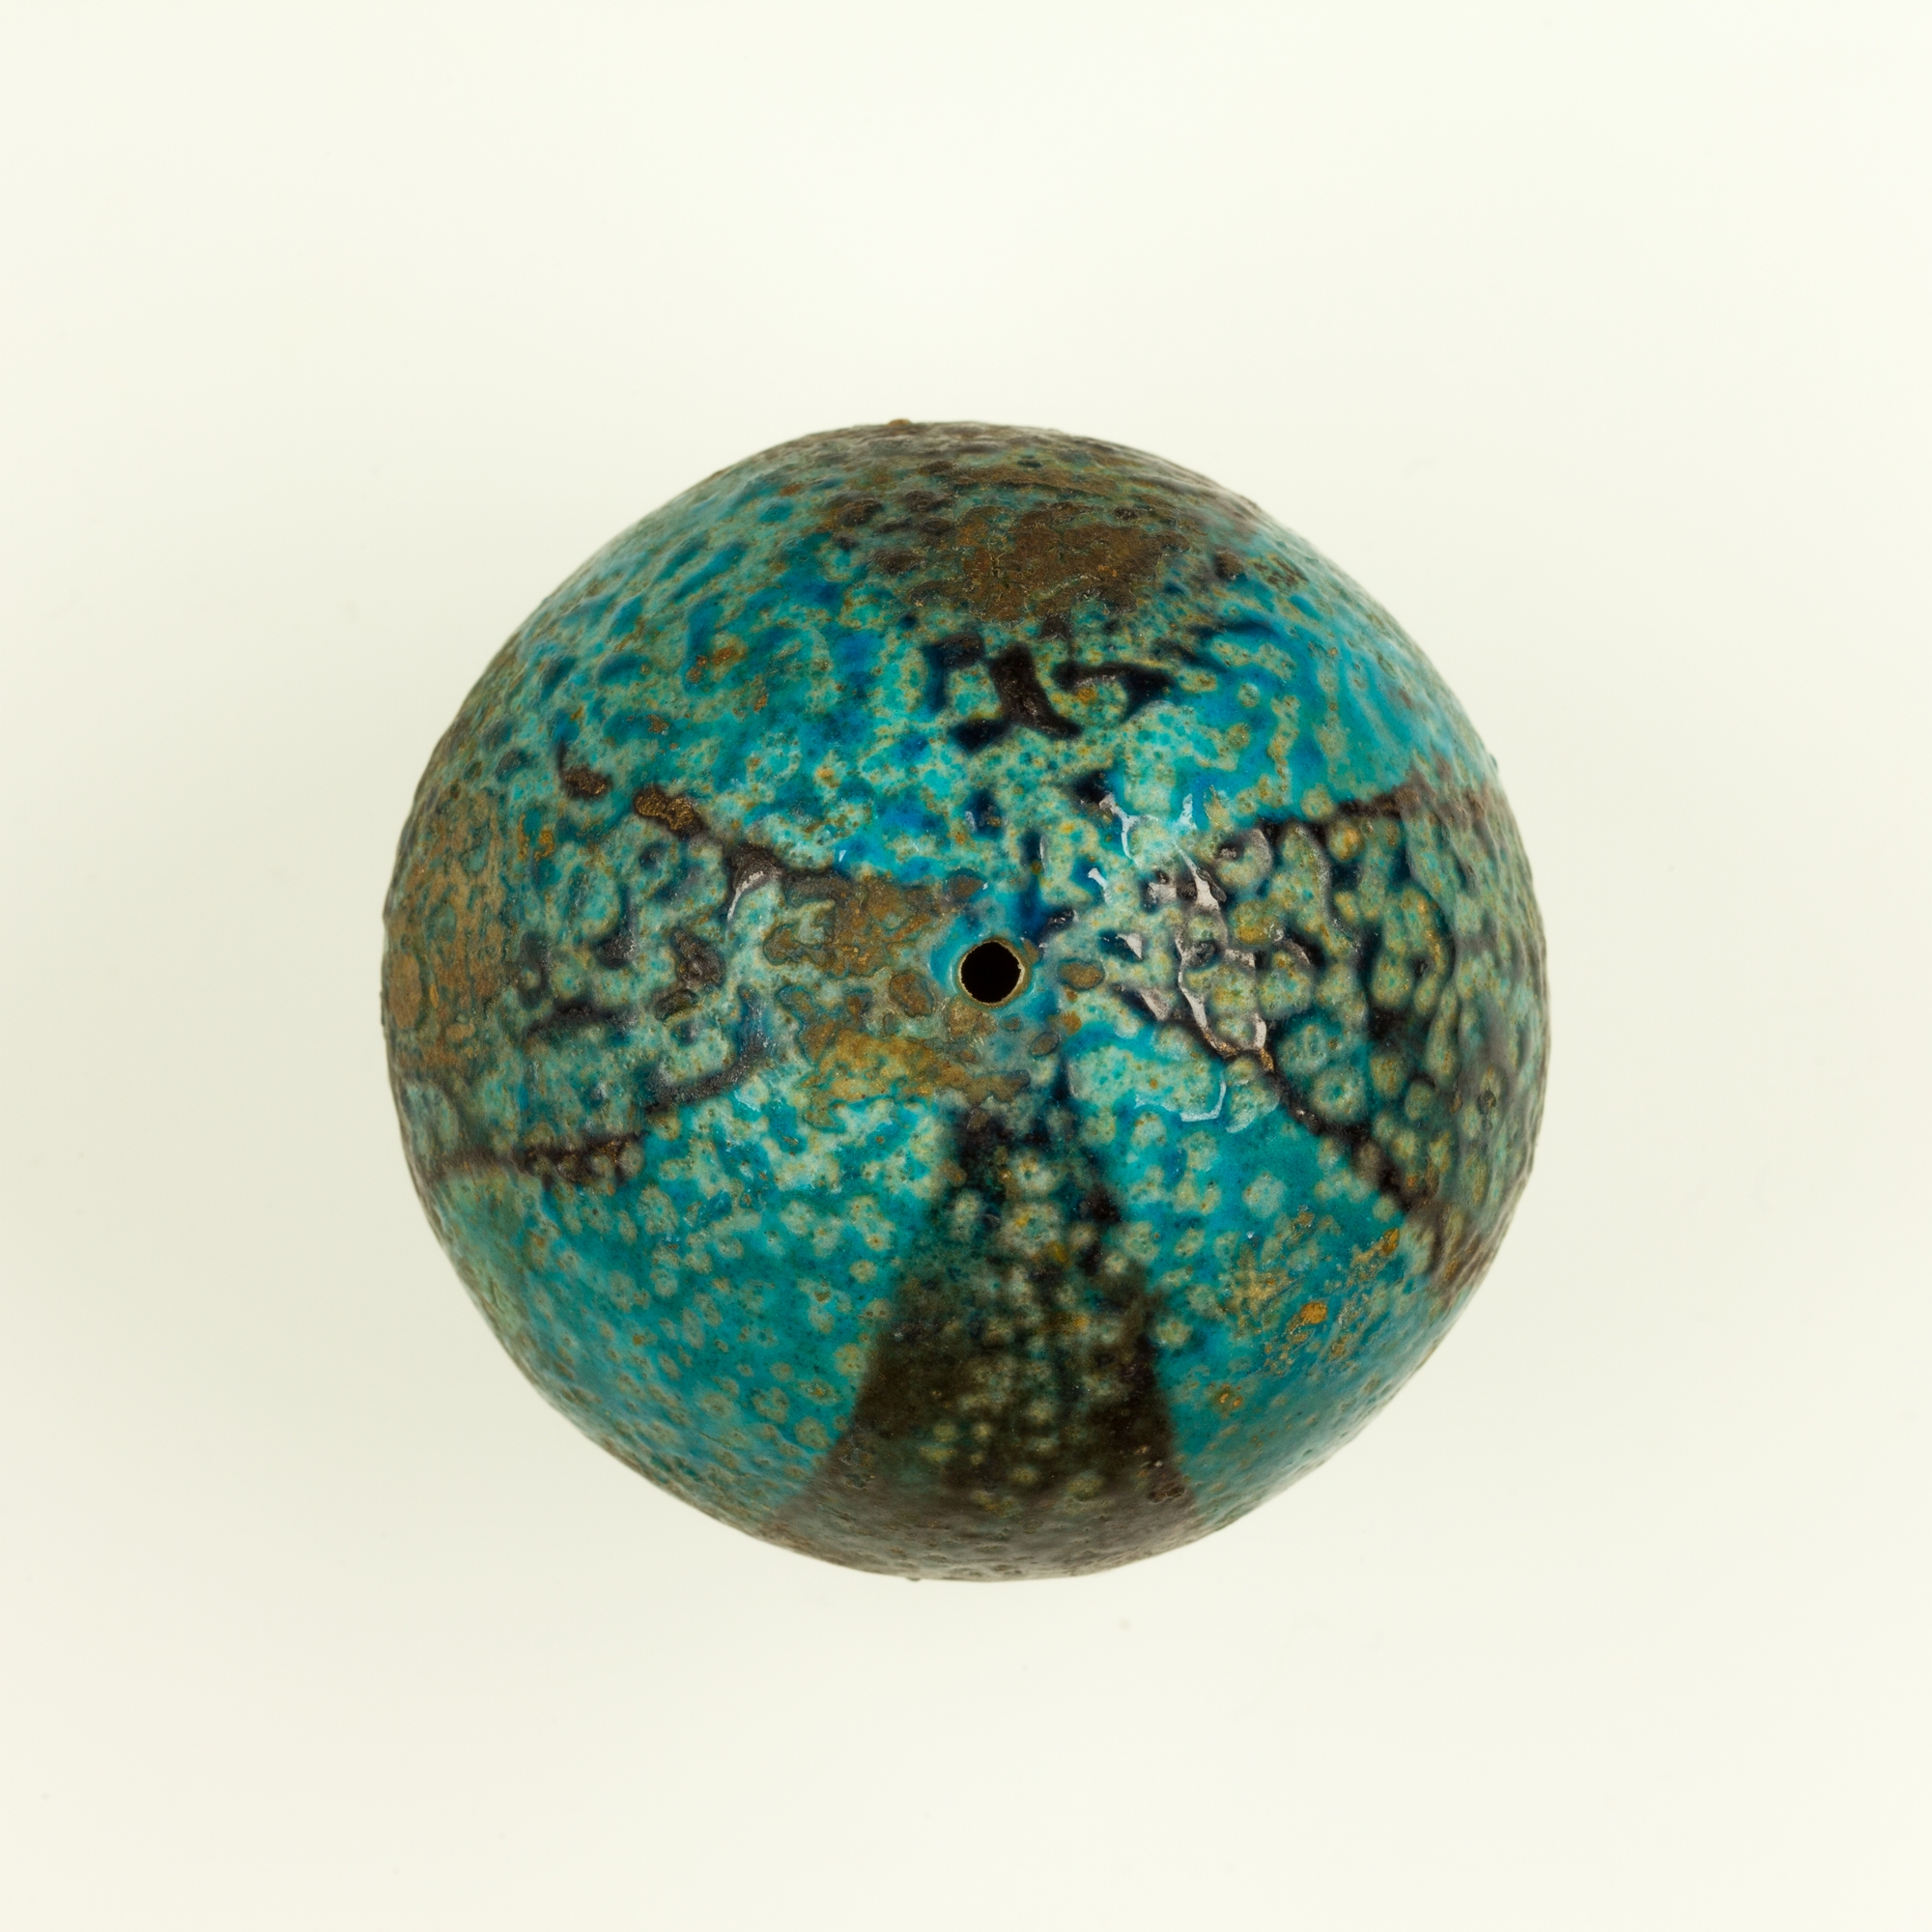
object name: bead, ball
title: Ball bead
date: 1635-1458 BCE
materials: faience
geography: egypt